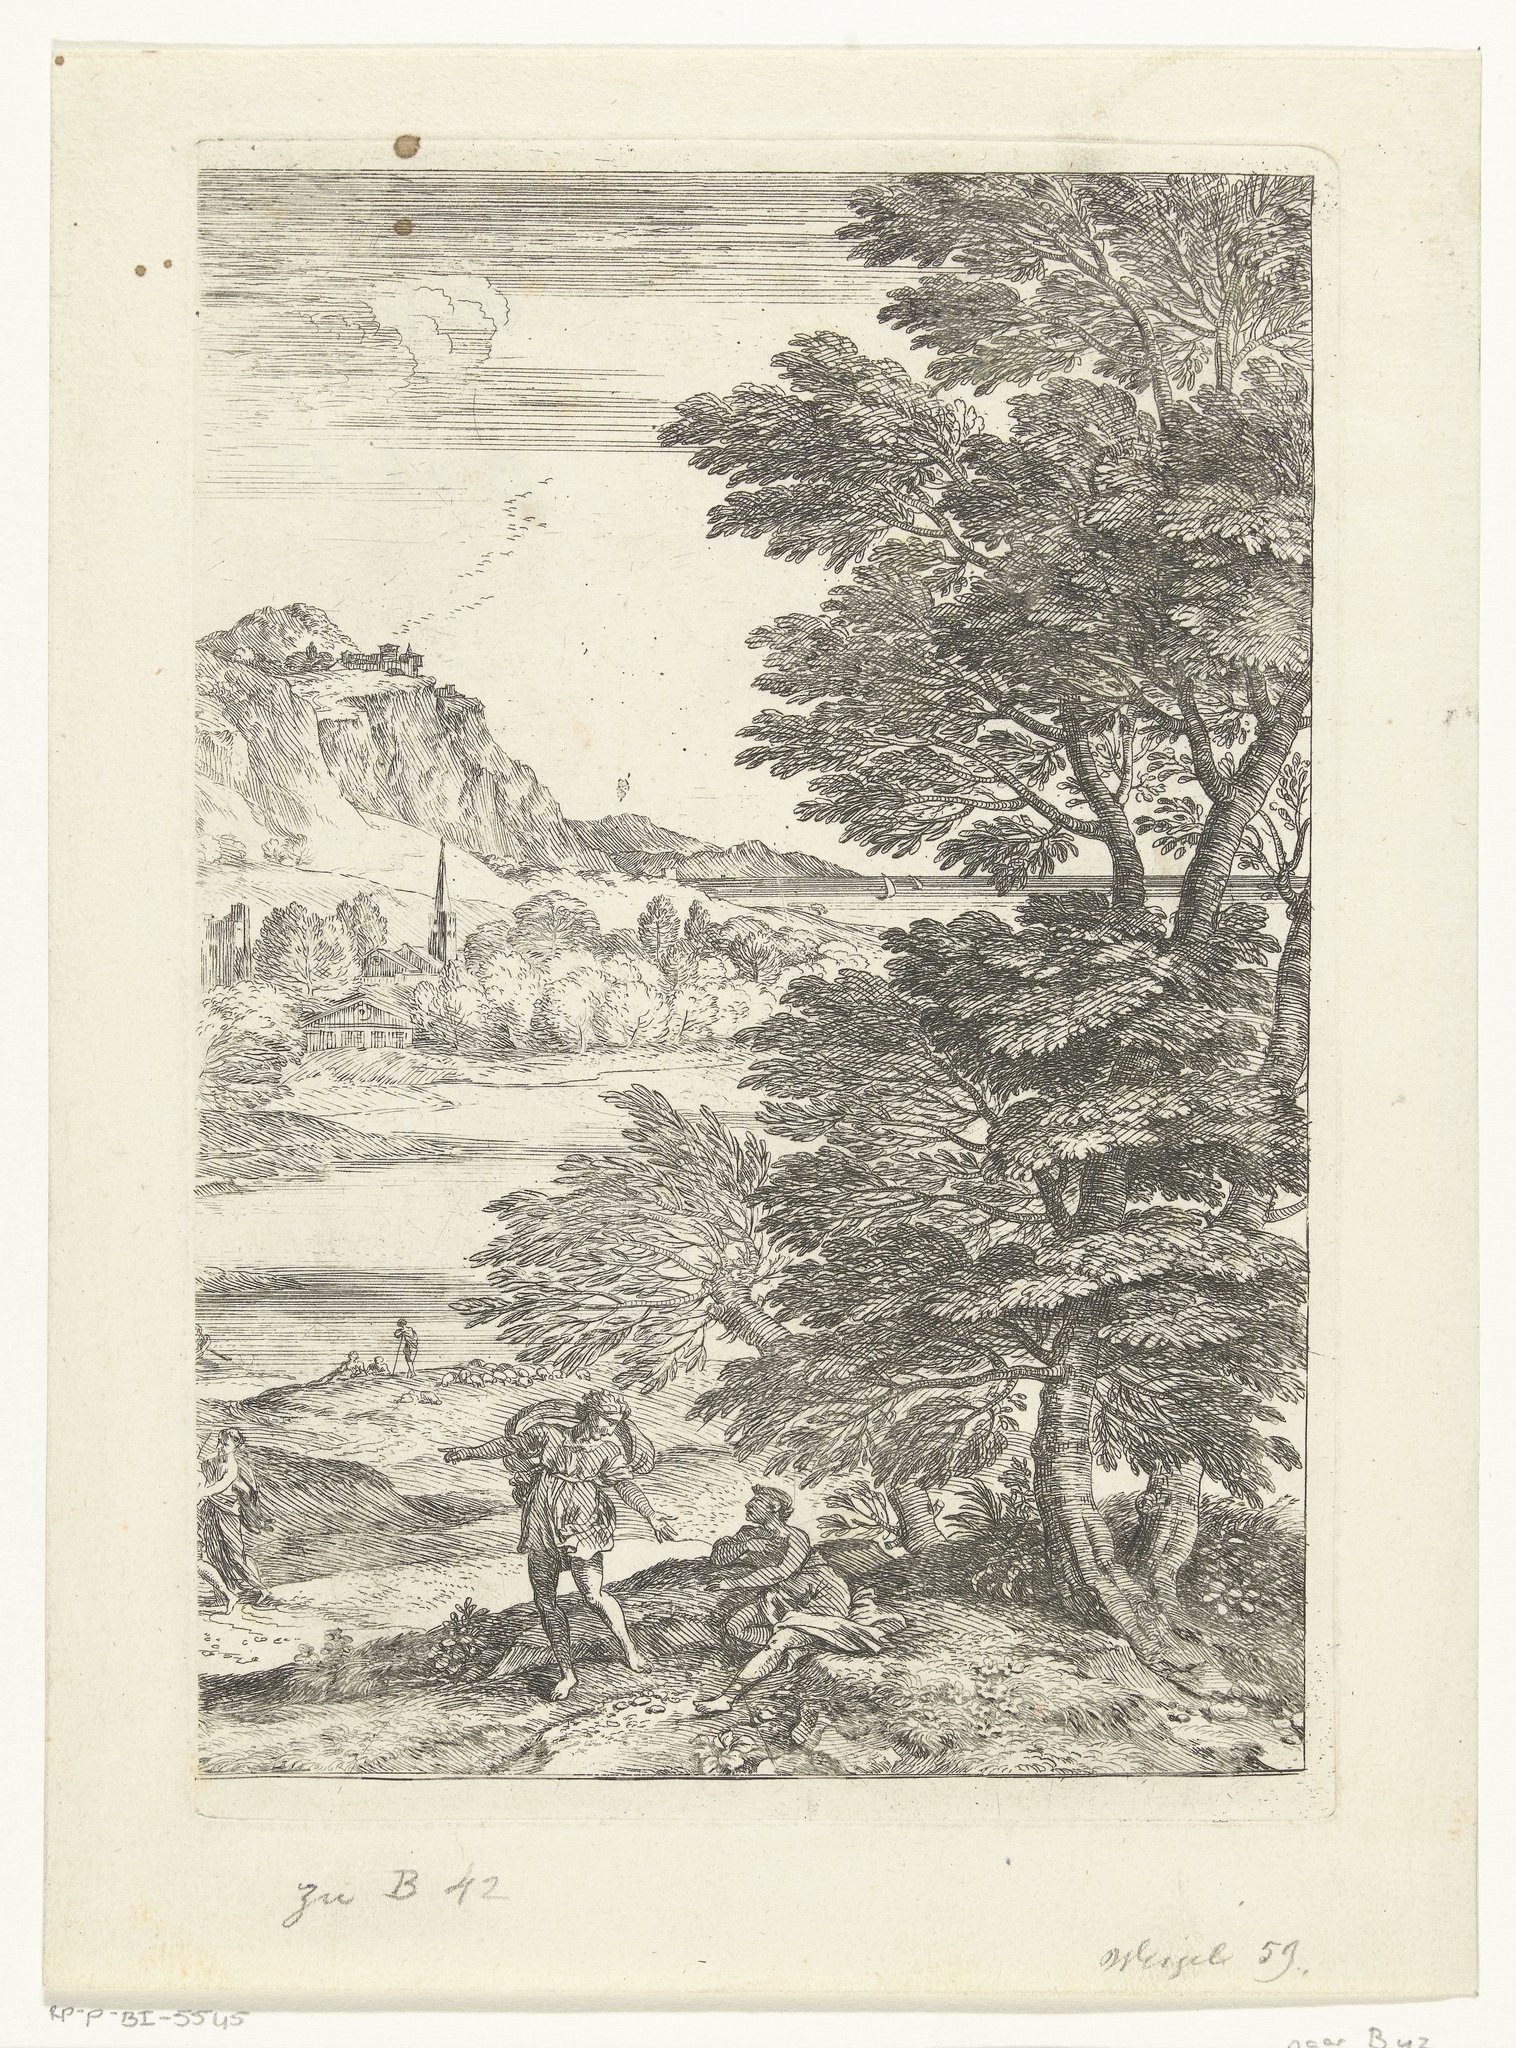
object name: print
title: Landschap met man zittend onder boom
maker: adriaen van der kabel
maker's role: draughtsman, painter, print maker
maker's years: 1630-1705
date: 1648-1705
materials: paper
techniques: etching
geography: france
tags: landscapes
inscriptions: collector's mark: Lugt 240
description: Man met opbollende mantel, de armen gespreid, staand bij onder hoge boom zittende man. Aan de waterkant een herder met kudde schapen. Op de achtergrond een kerktoren tussen bomen. Tegen de linker marge twee personen waarvan de voorste slechts deels zichtbaar.